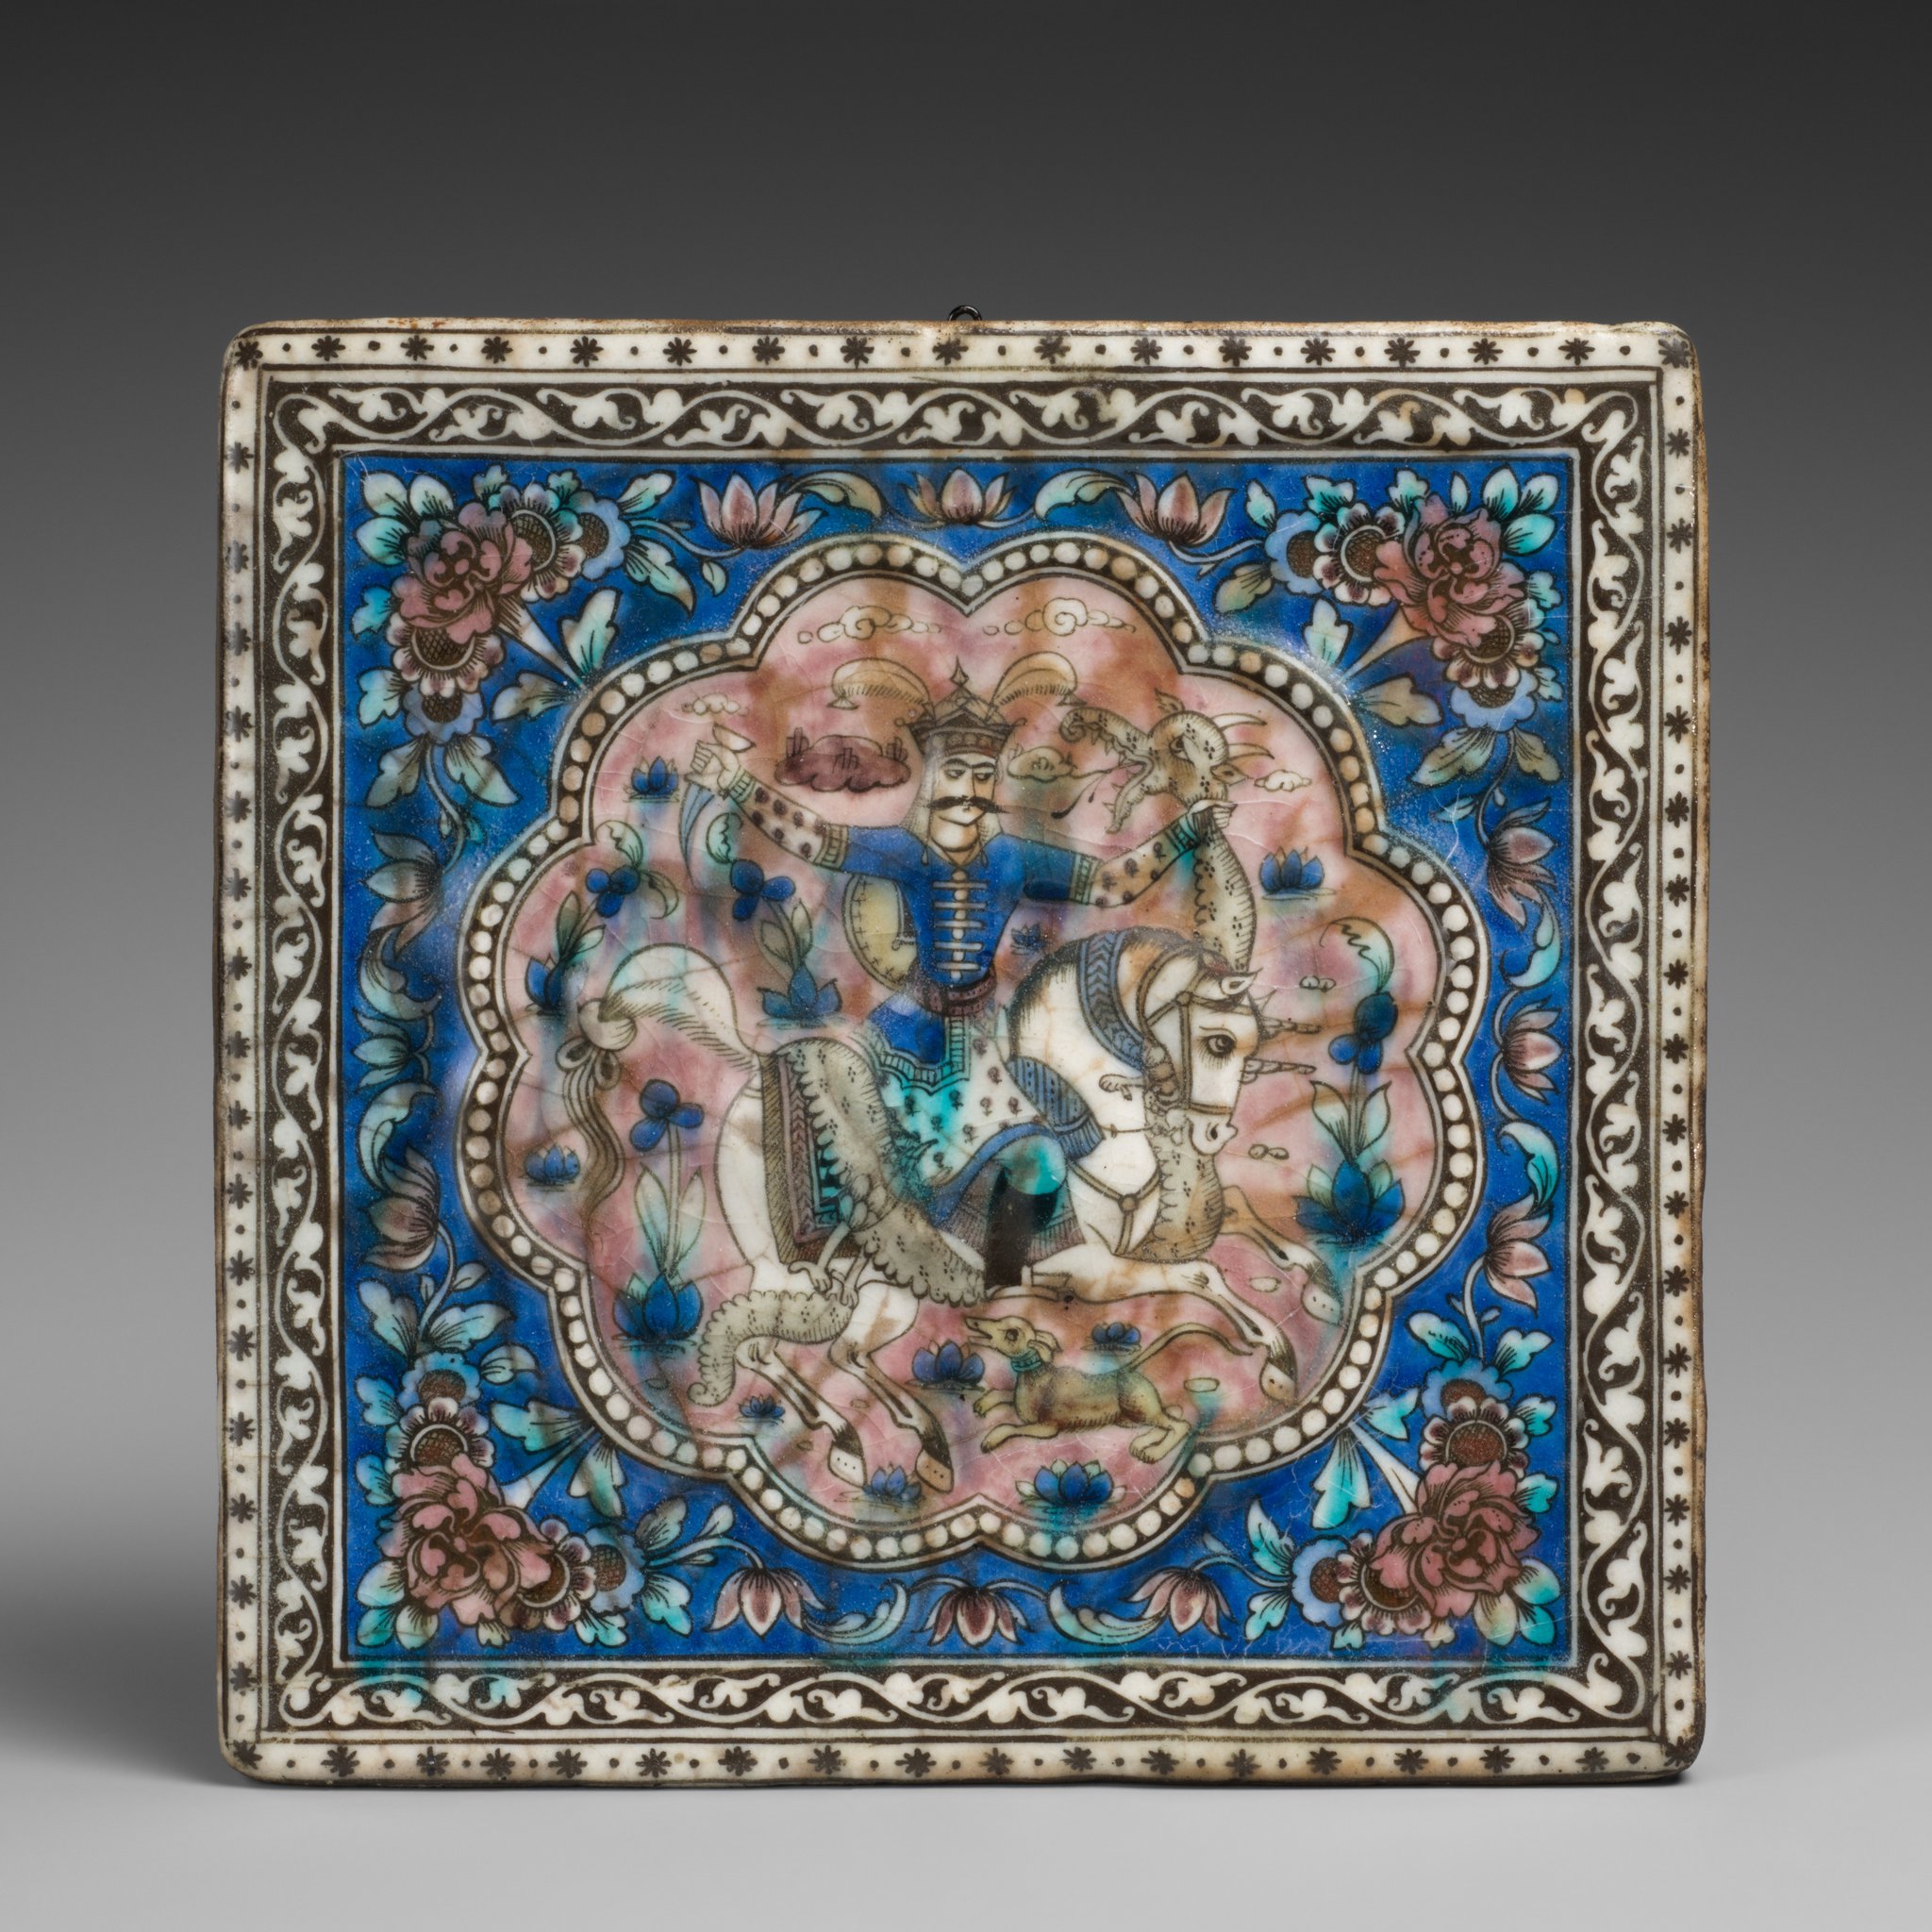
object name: tile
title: Square Tile Depicting a Horseman Killing a Dragon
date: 1851-1875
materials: glaze, stonepaste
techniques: molding, painting, polychrome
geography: iran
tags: men,dogs,horses